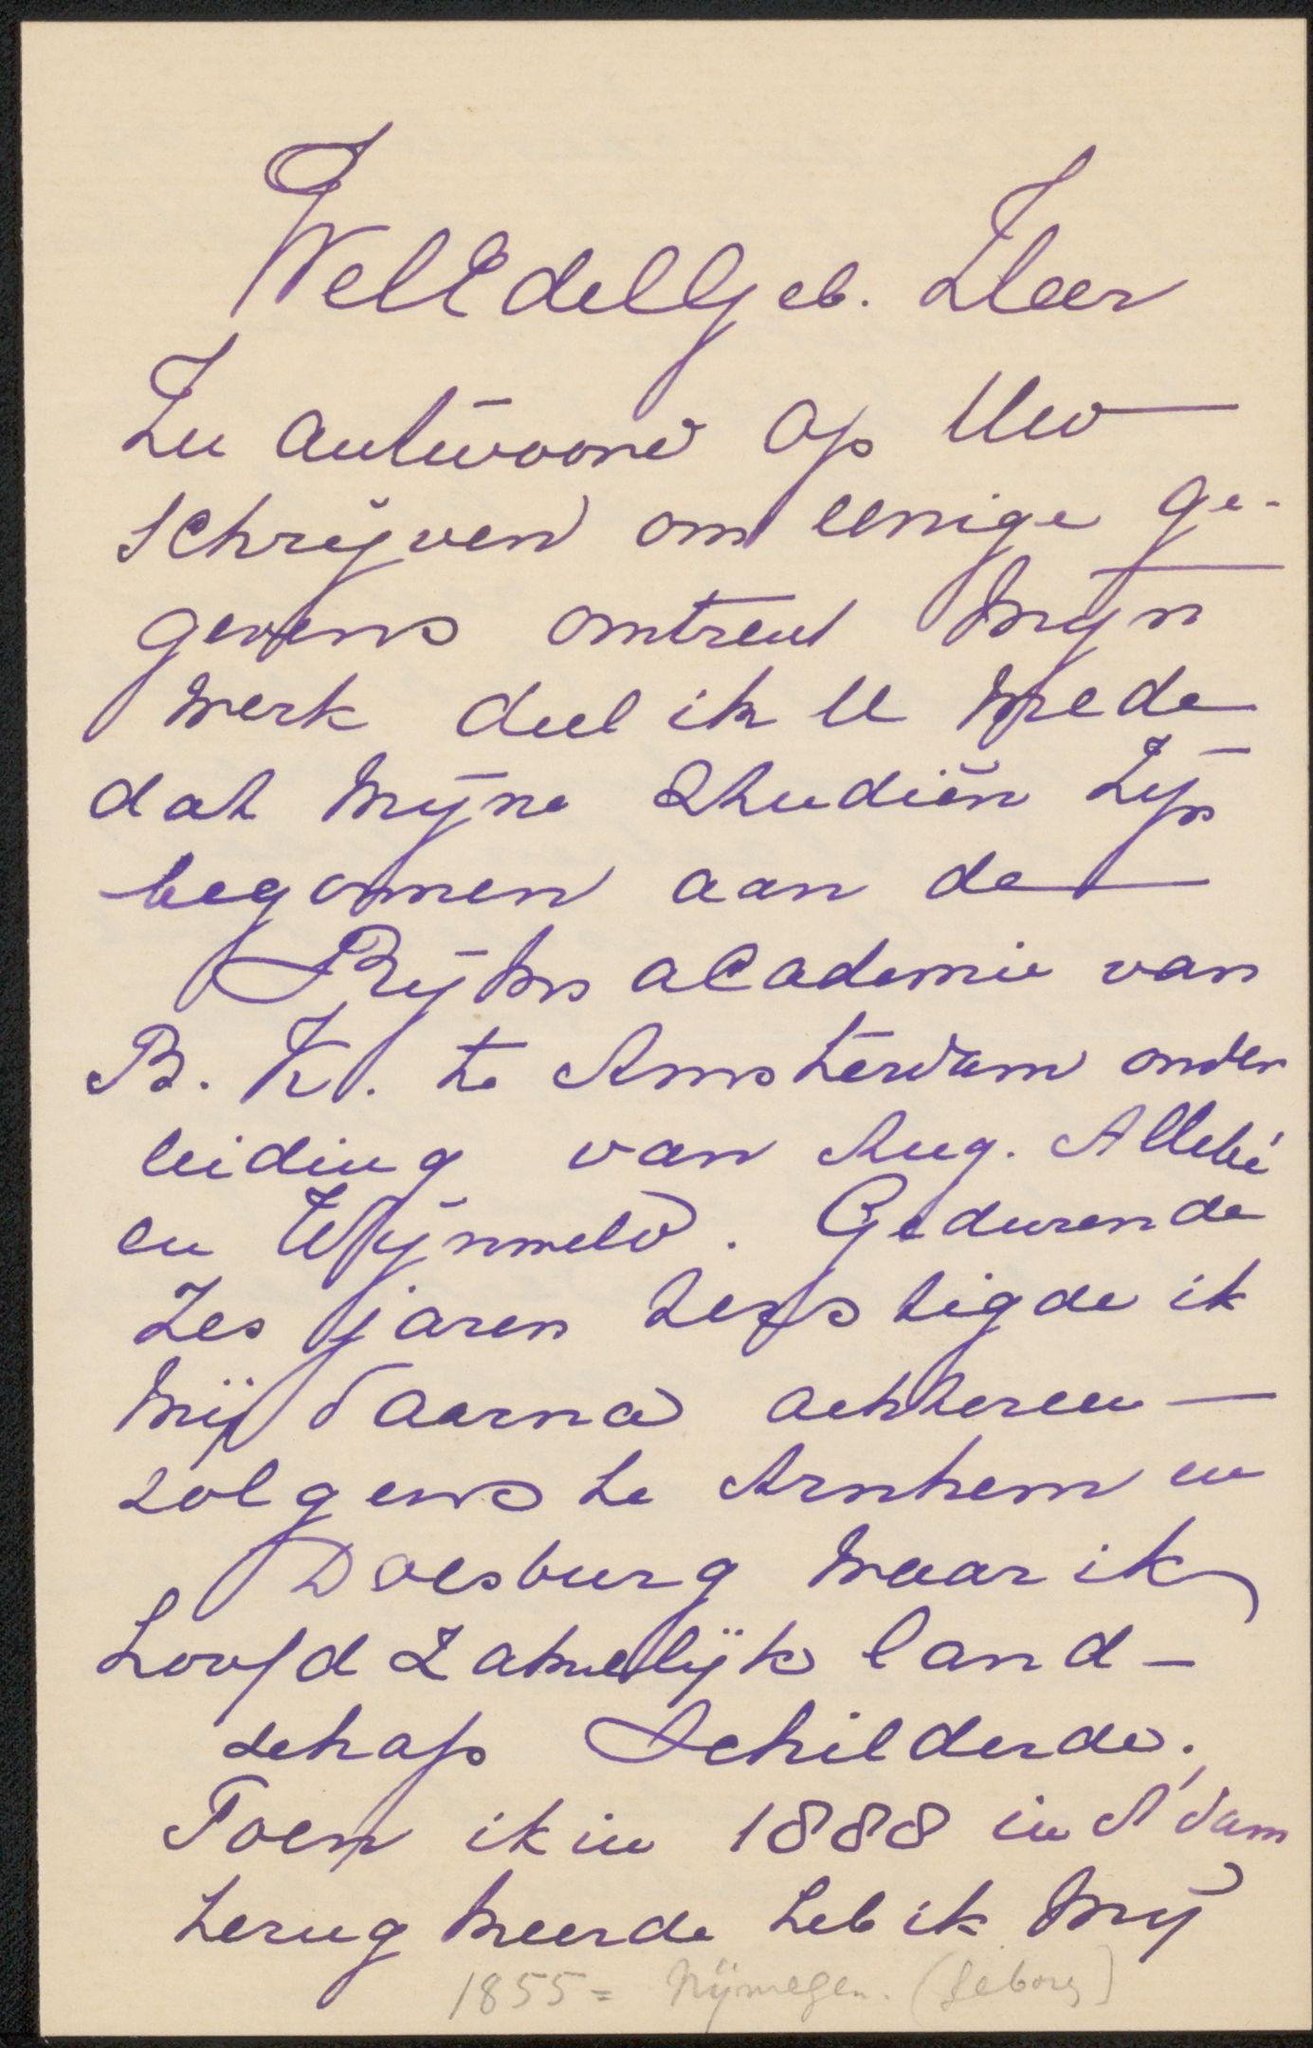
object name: letter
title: Brief aan Philip Zilcken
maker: hendrik willebrord jansen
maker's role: painter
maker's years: 1855-1908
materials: ink, paper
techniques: pen, writing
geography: amsterdam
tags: august allebé, hendrikus theodorus wijdeveld, the hague, philip zilcken, distribution of awards ~ art contest, painting (including book-illumination, miniature-painting), amsterdam, arnhem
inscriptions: collector's mark: ‘RPK’